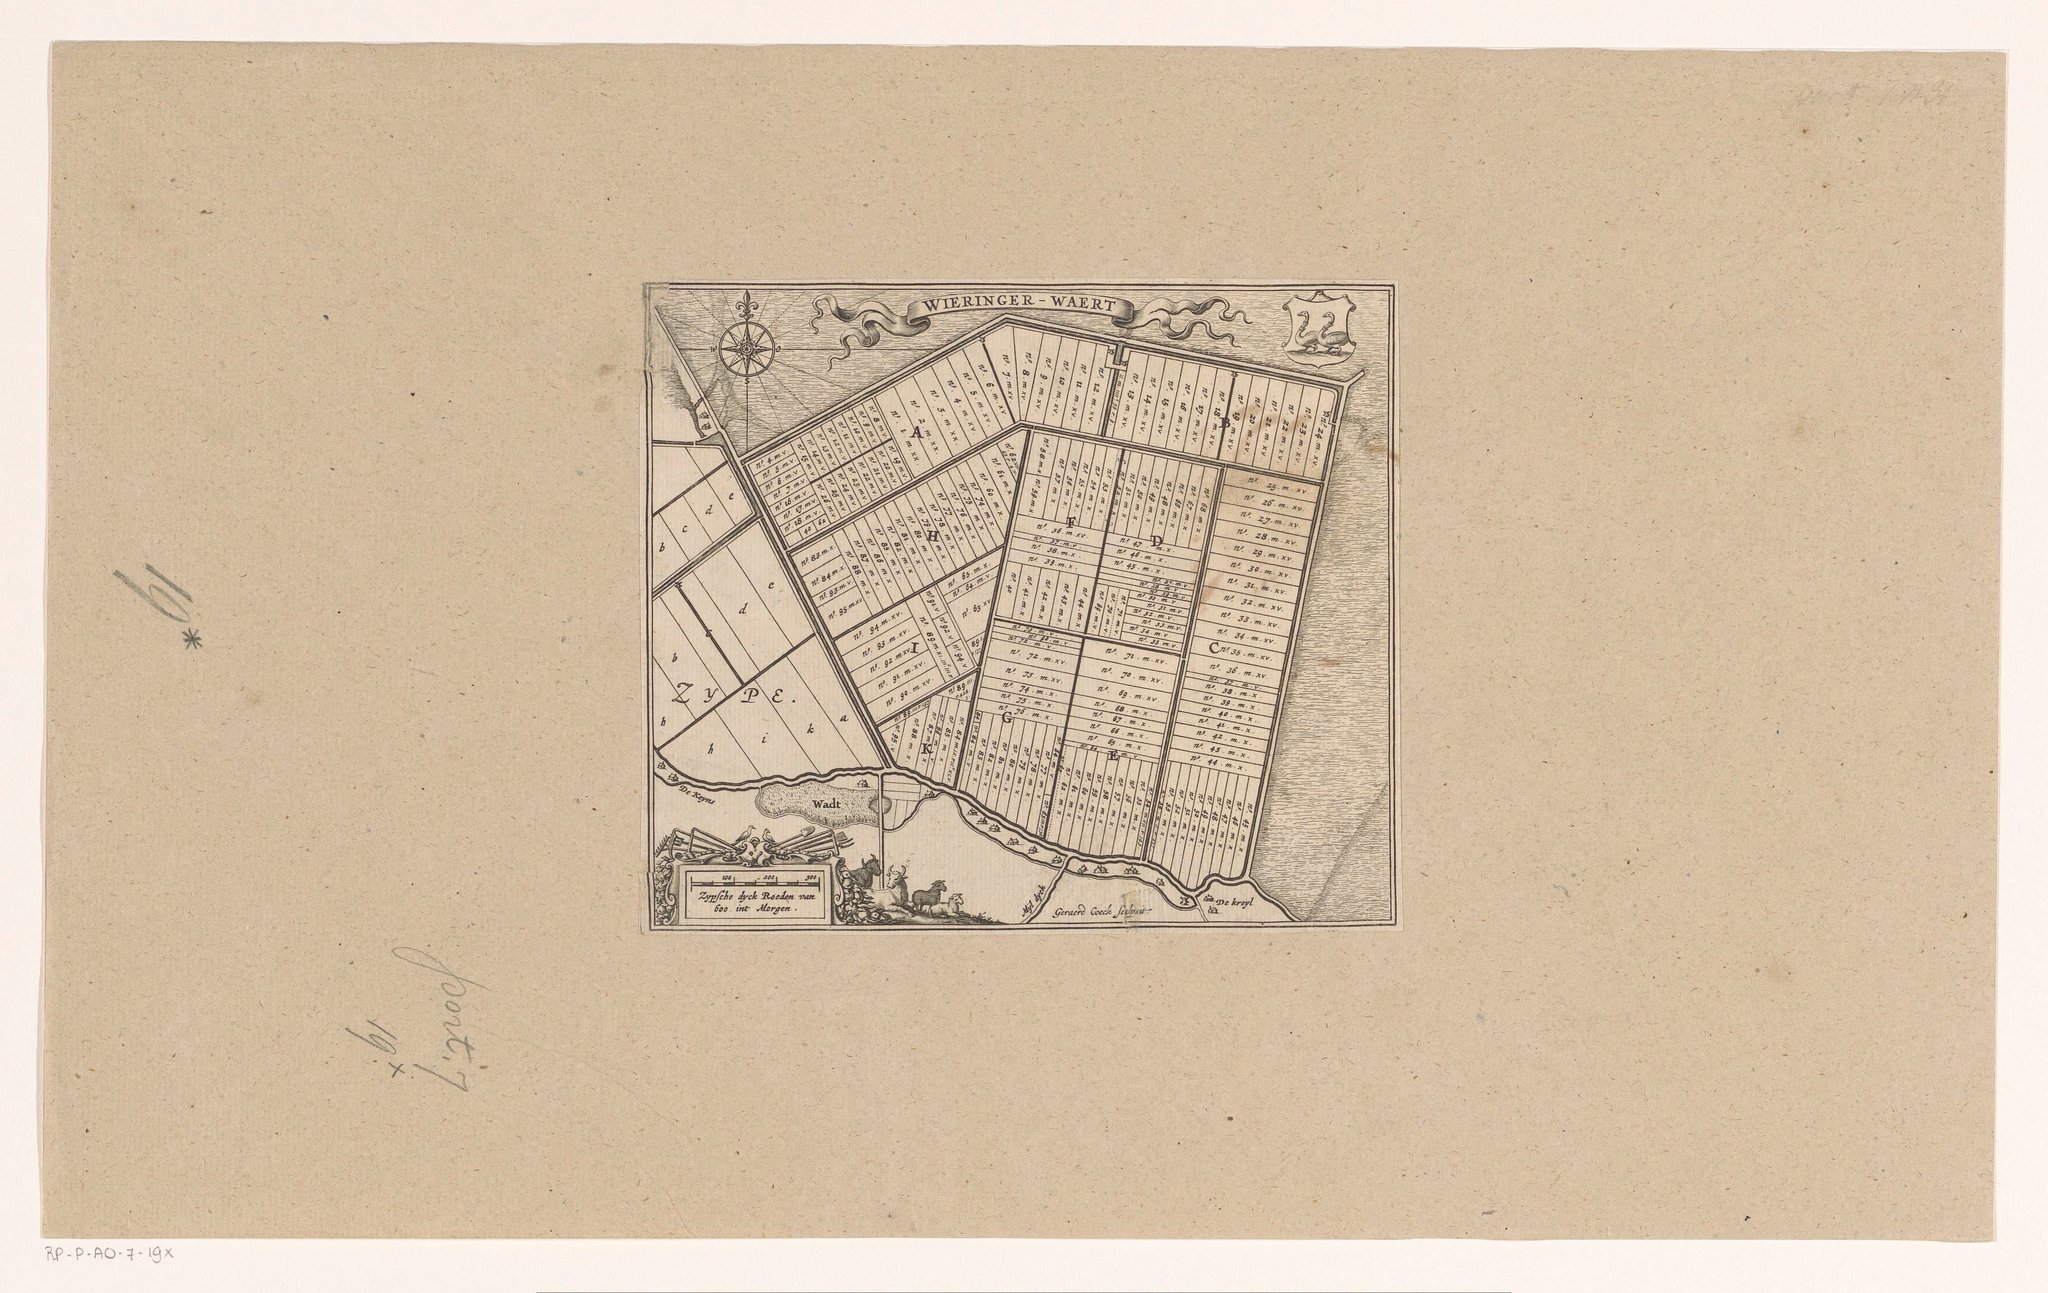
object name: print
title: Kaart van de kavels van de Wieringerwaard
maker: gerard coeck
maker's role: print maker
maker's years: 1608-1649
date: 1623-1649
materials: paper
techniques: engraving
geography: amsterdam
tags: maps of separate countries or regions, polder, reclaimed land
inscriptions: collector's mark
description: Kaart van de kavels van de Wieringerwaard, zoals verloot op 12 juli 1611. Boven in het midden de titel, rechts daarvan het wapen van Wieringerwaard. Linksonder een schaalstok: Zypsche dyck roeden van 600 int morgen.